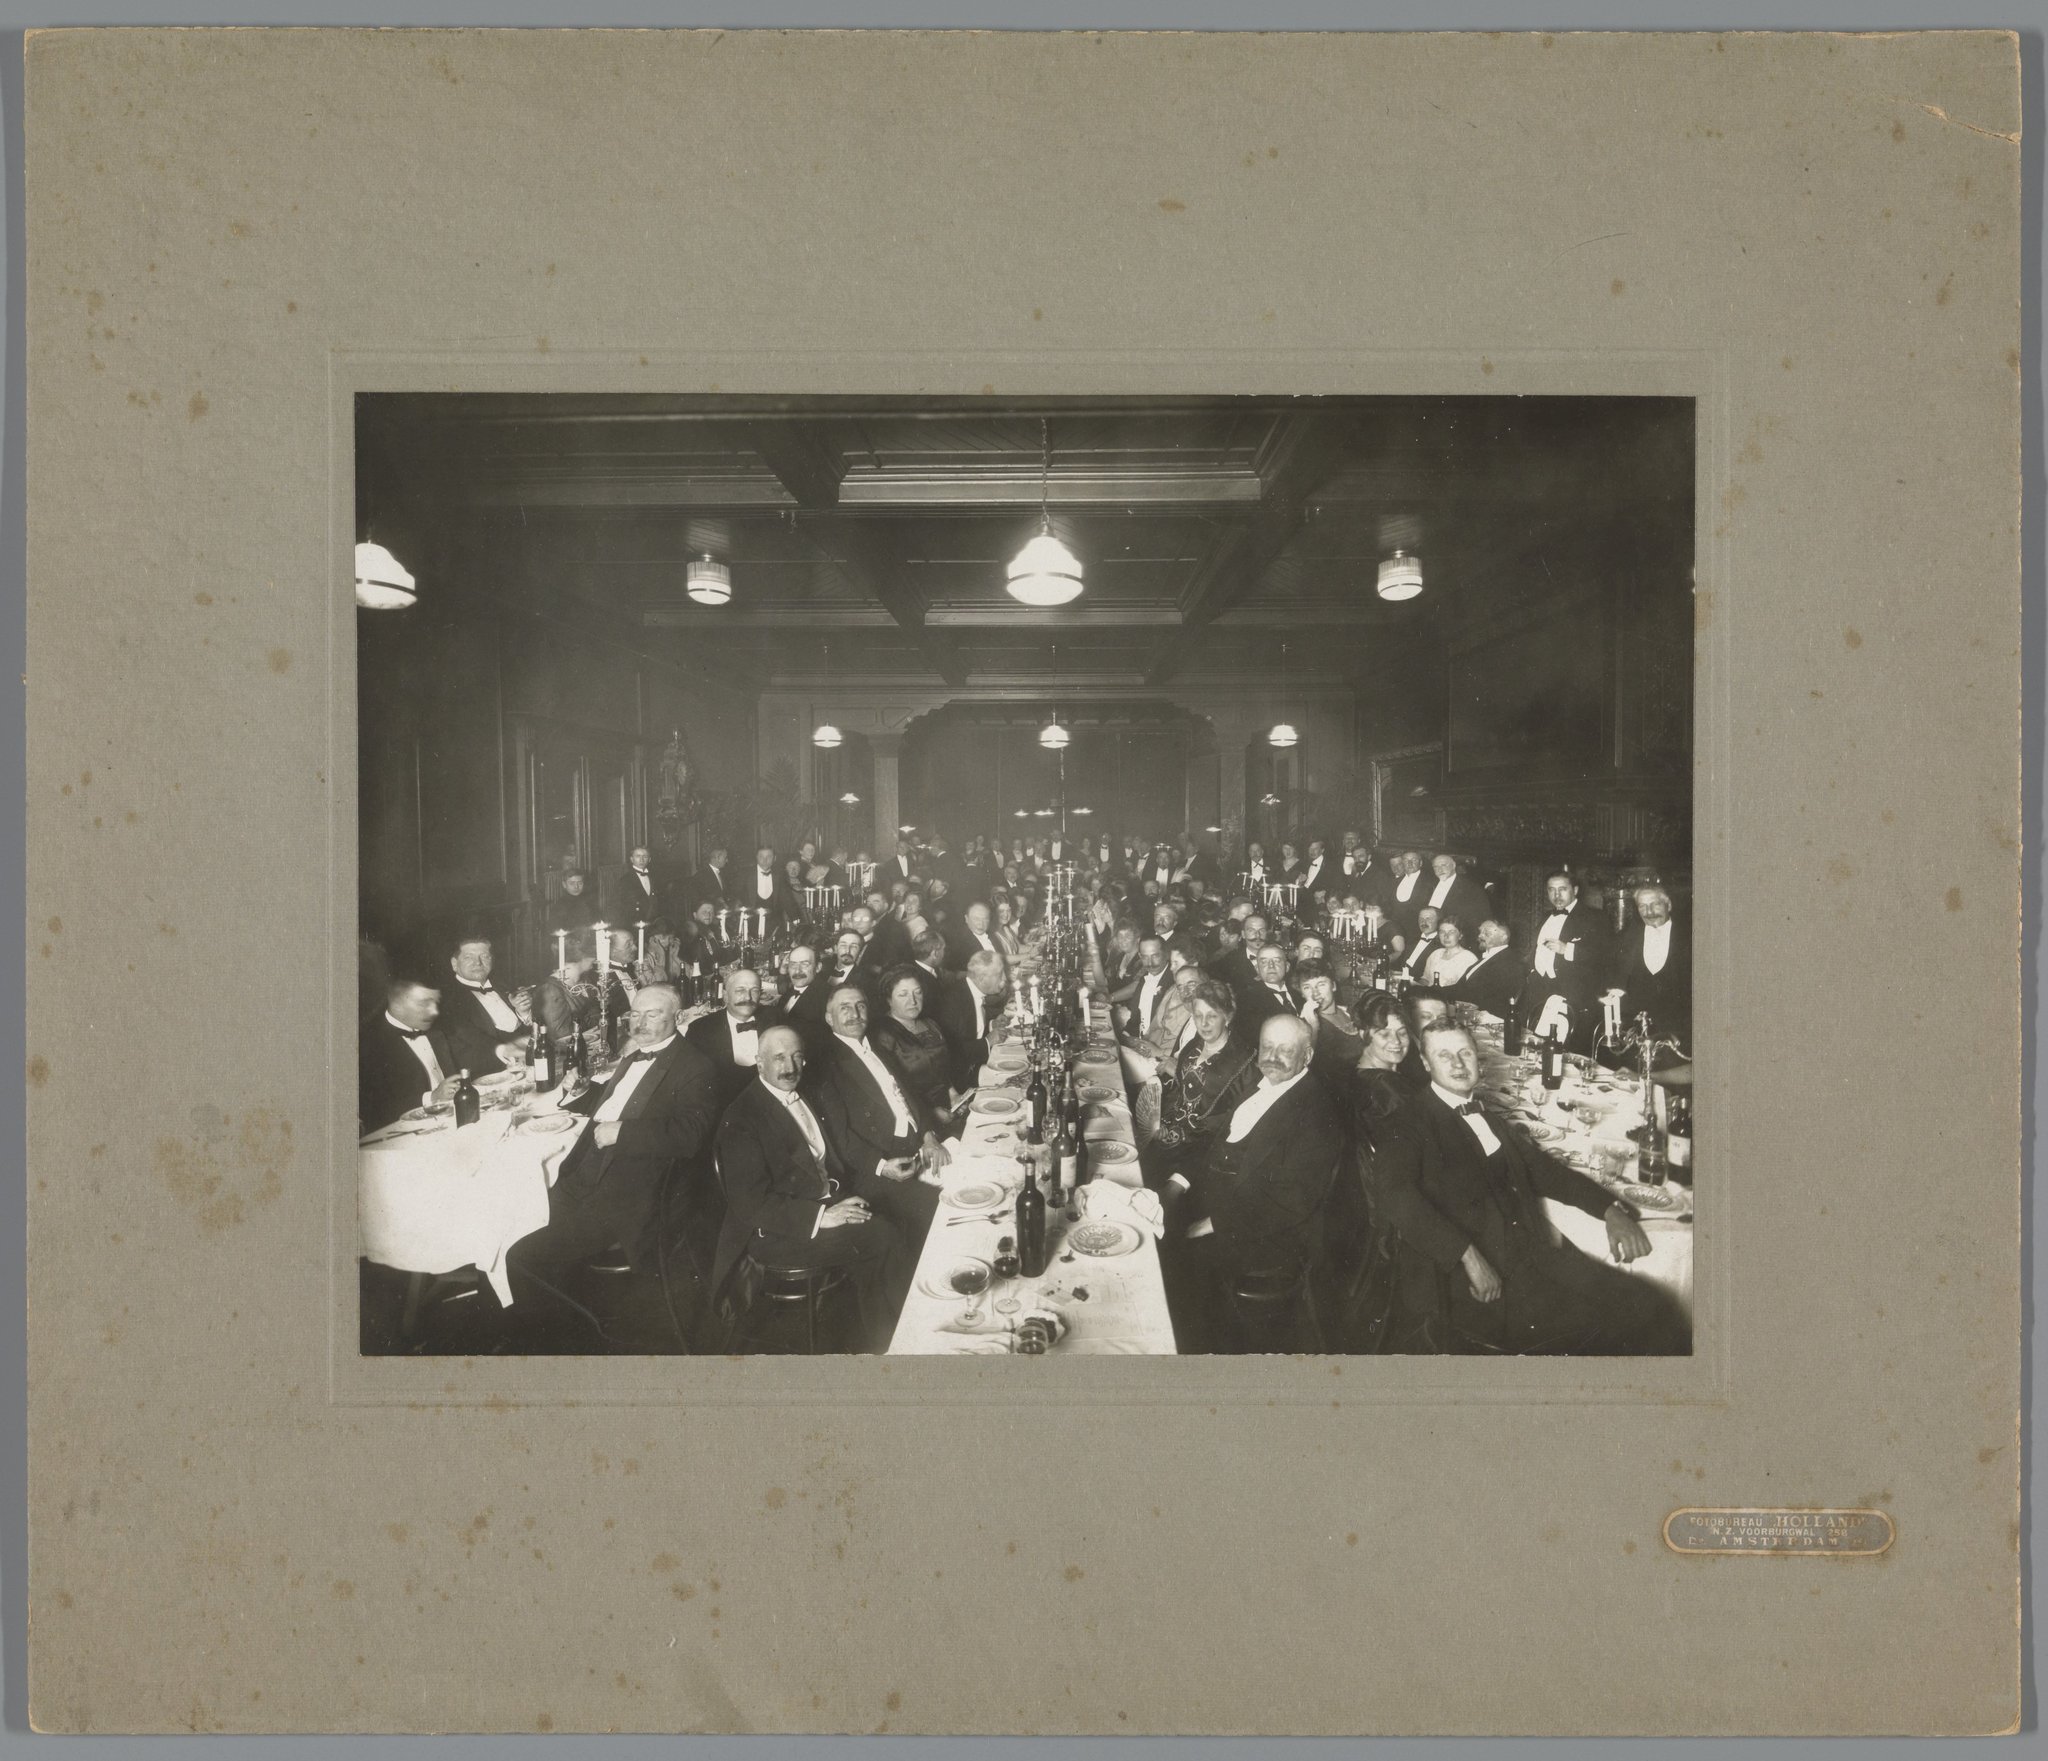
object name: photograph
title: Groep mensen aan een diner in Amsterdam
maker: Anonymous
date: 1860-1915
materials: cardboard, paper, photographic support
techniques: gelatin silver print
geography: amsterdam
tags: amsterdam